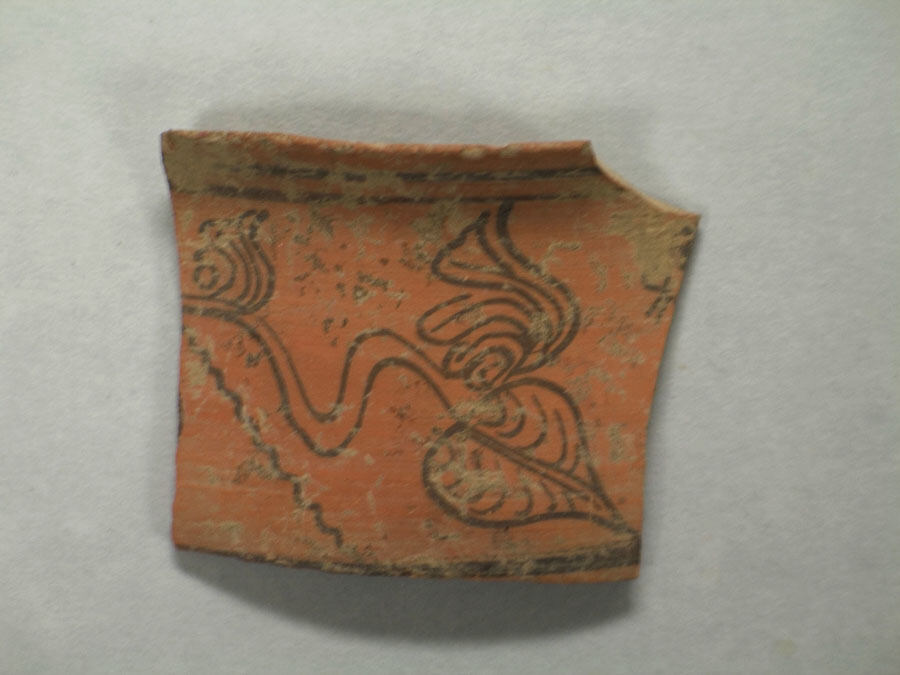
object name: shard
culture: pakistani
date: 301-500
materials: terracotta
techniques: painting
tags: gandhara,leaves